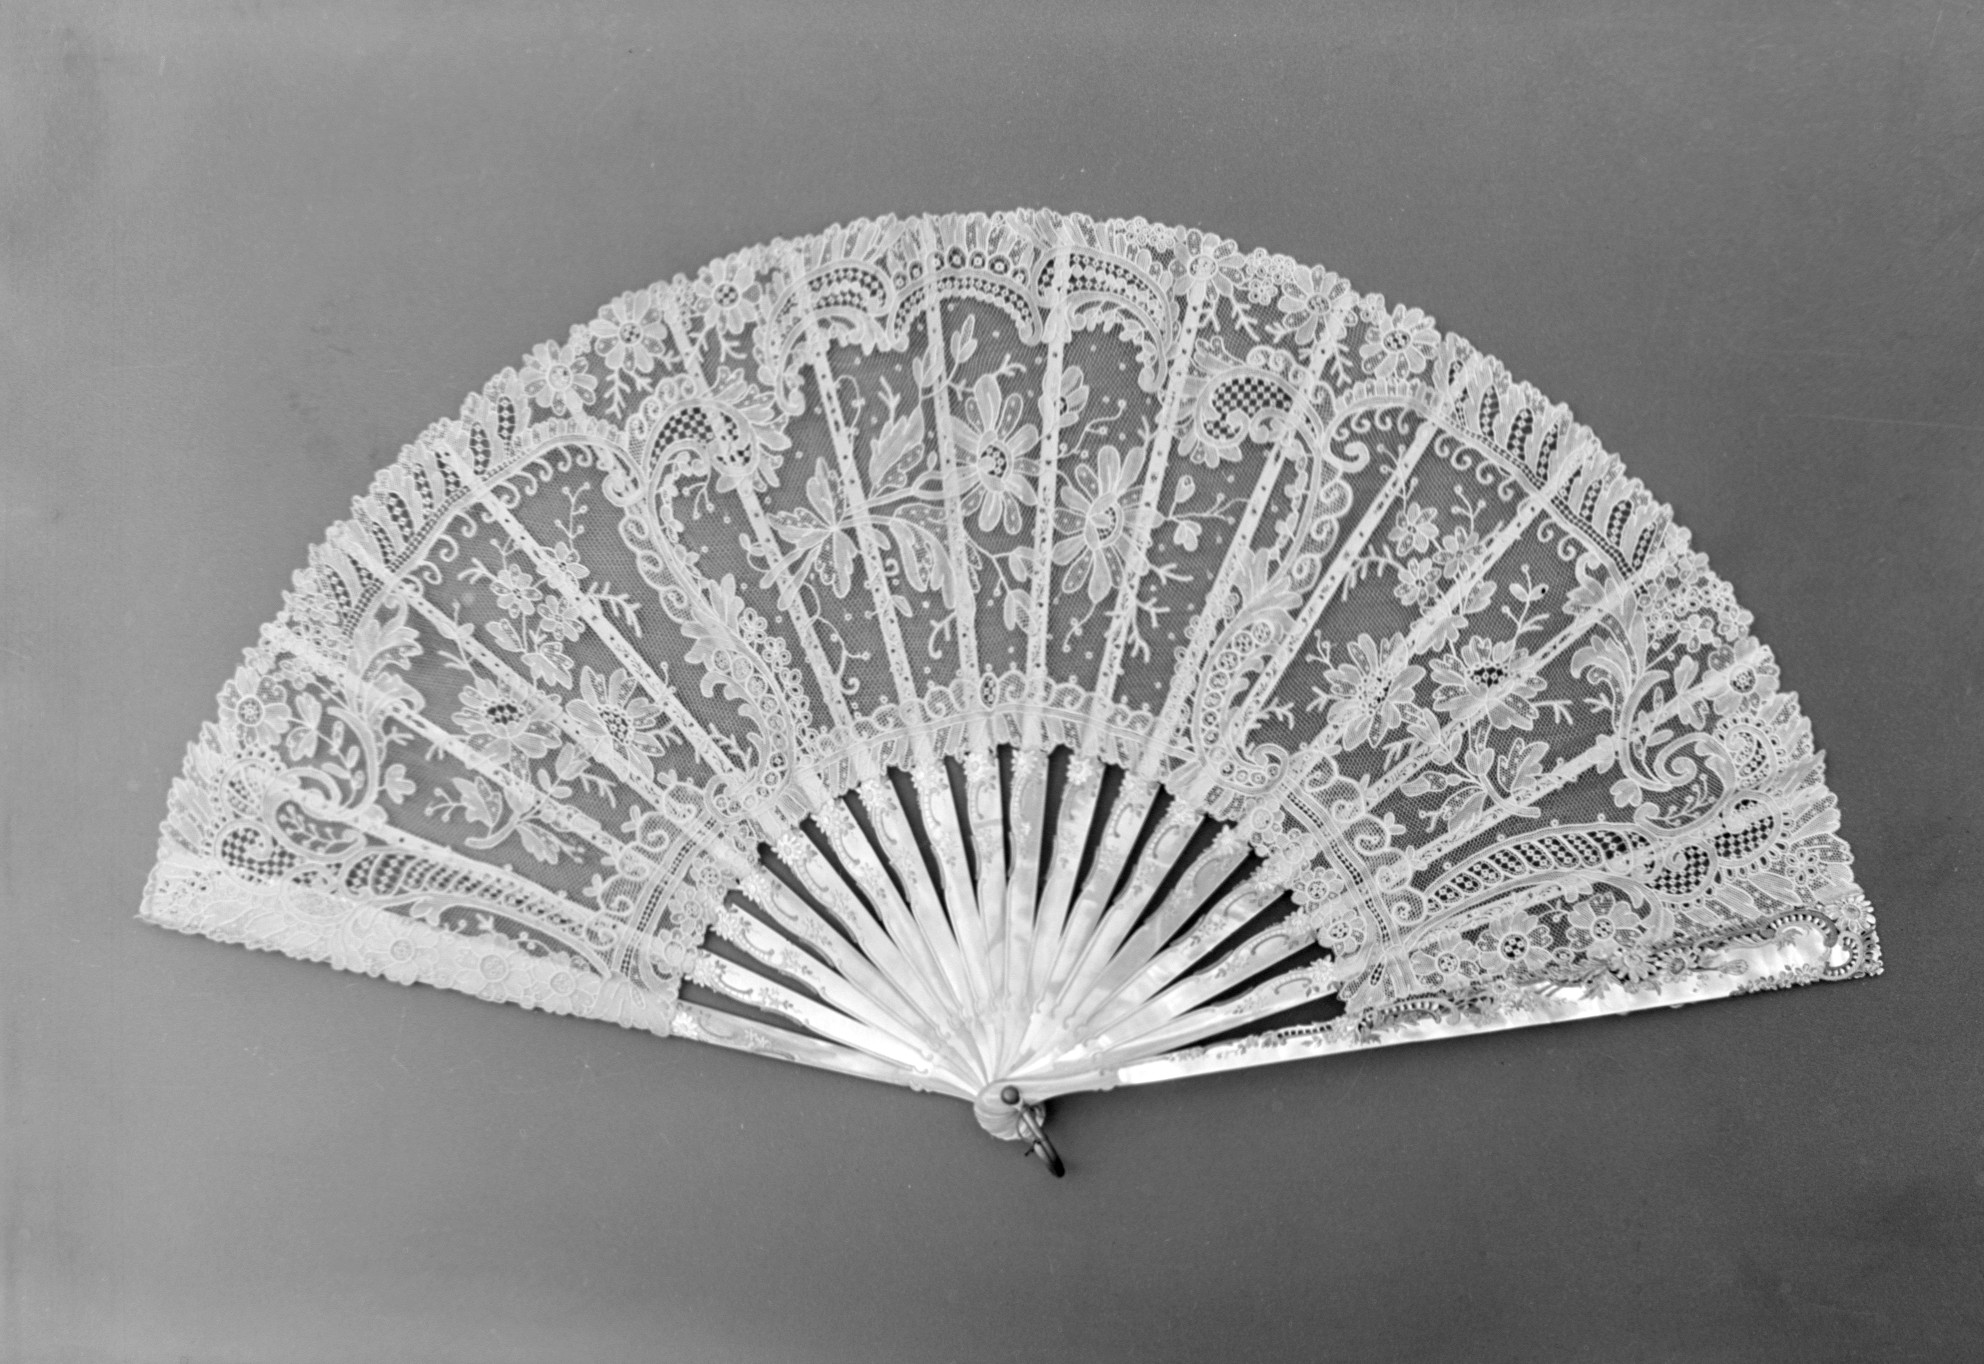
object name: fan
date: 1867-1900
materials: gilt, lace, mother of pearl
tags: flowers